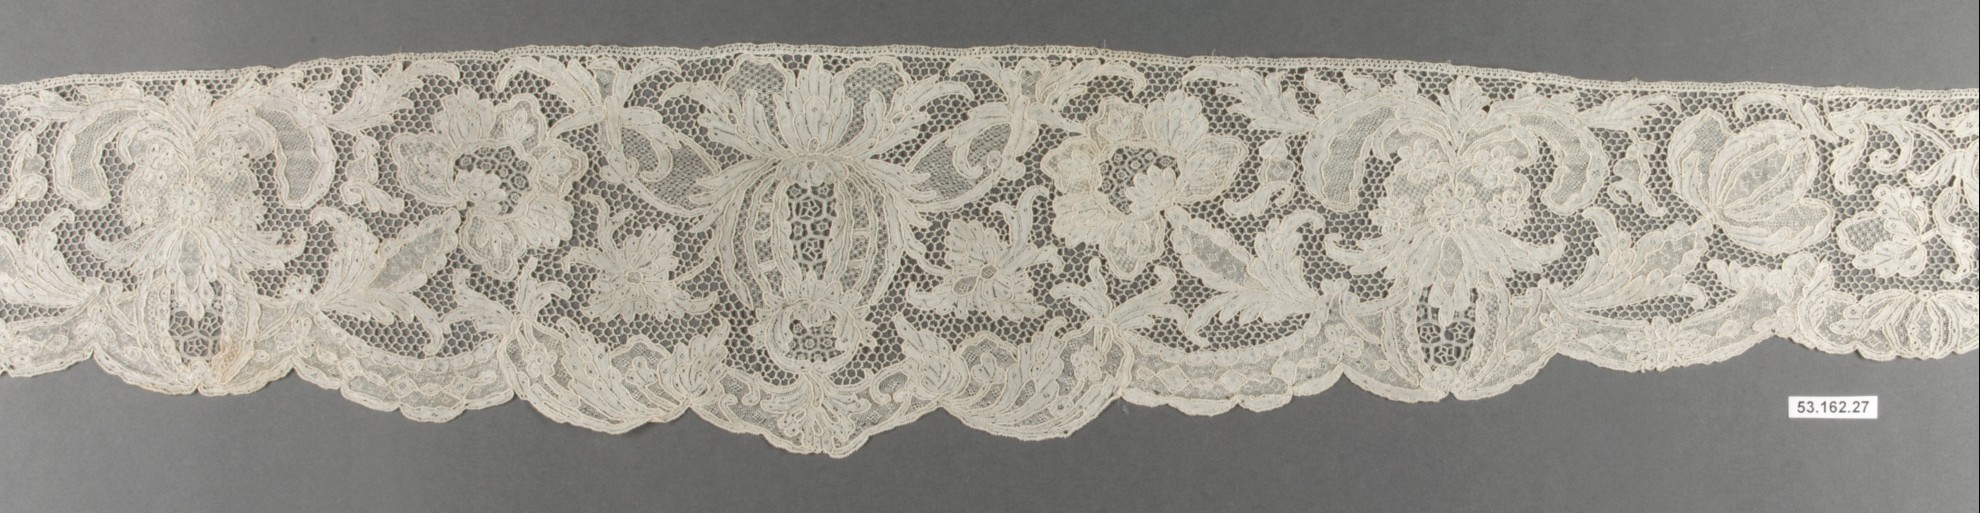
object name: sleeve piece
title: Sleeve piece (one of a pair)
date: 1701-1733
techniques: lace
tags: flowers